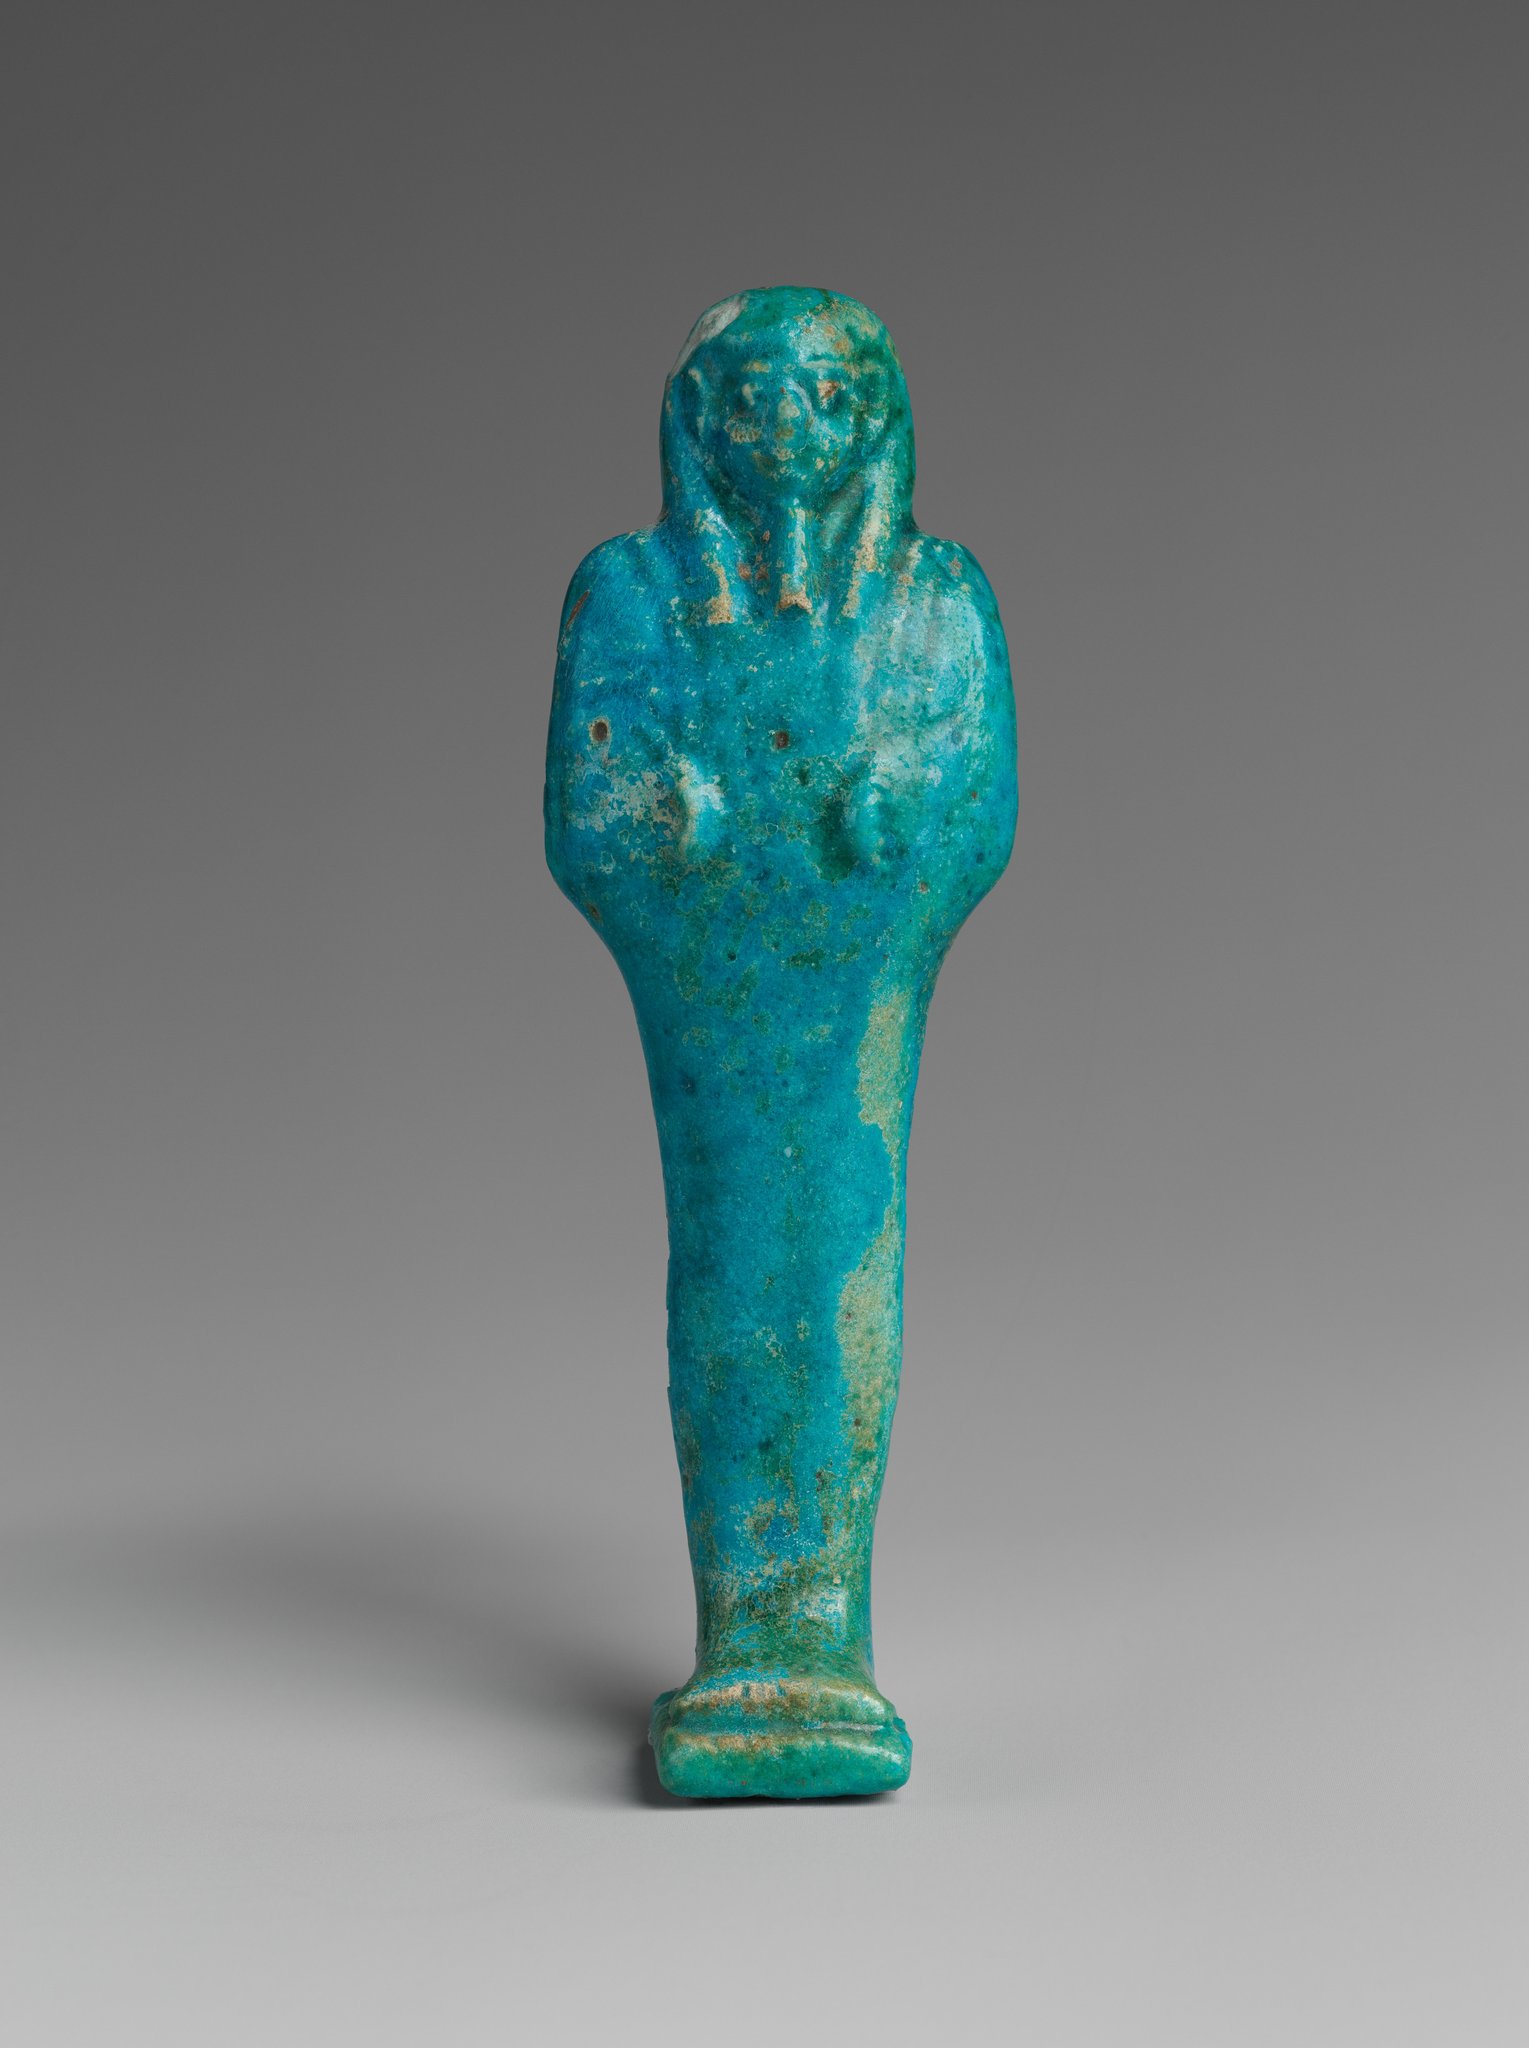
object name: shabti, djedhor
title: Shabti of Djedhor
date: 360-300 BCE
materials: faience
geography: egypt